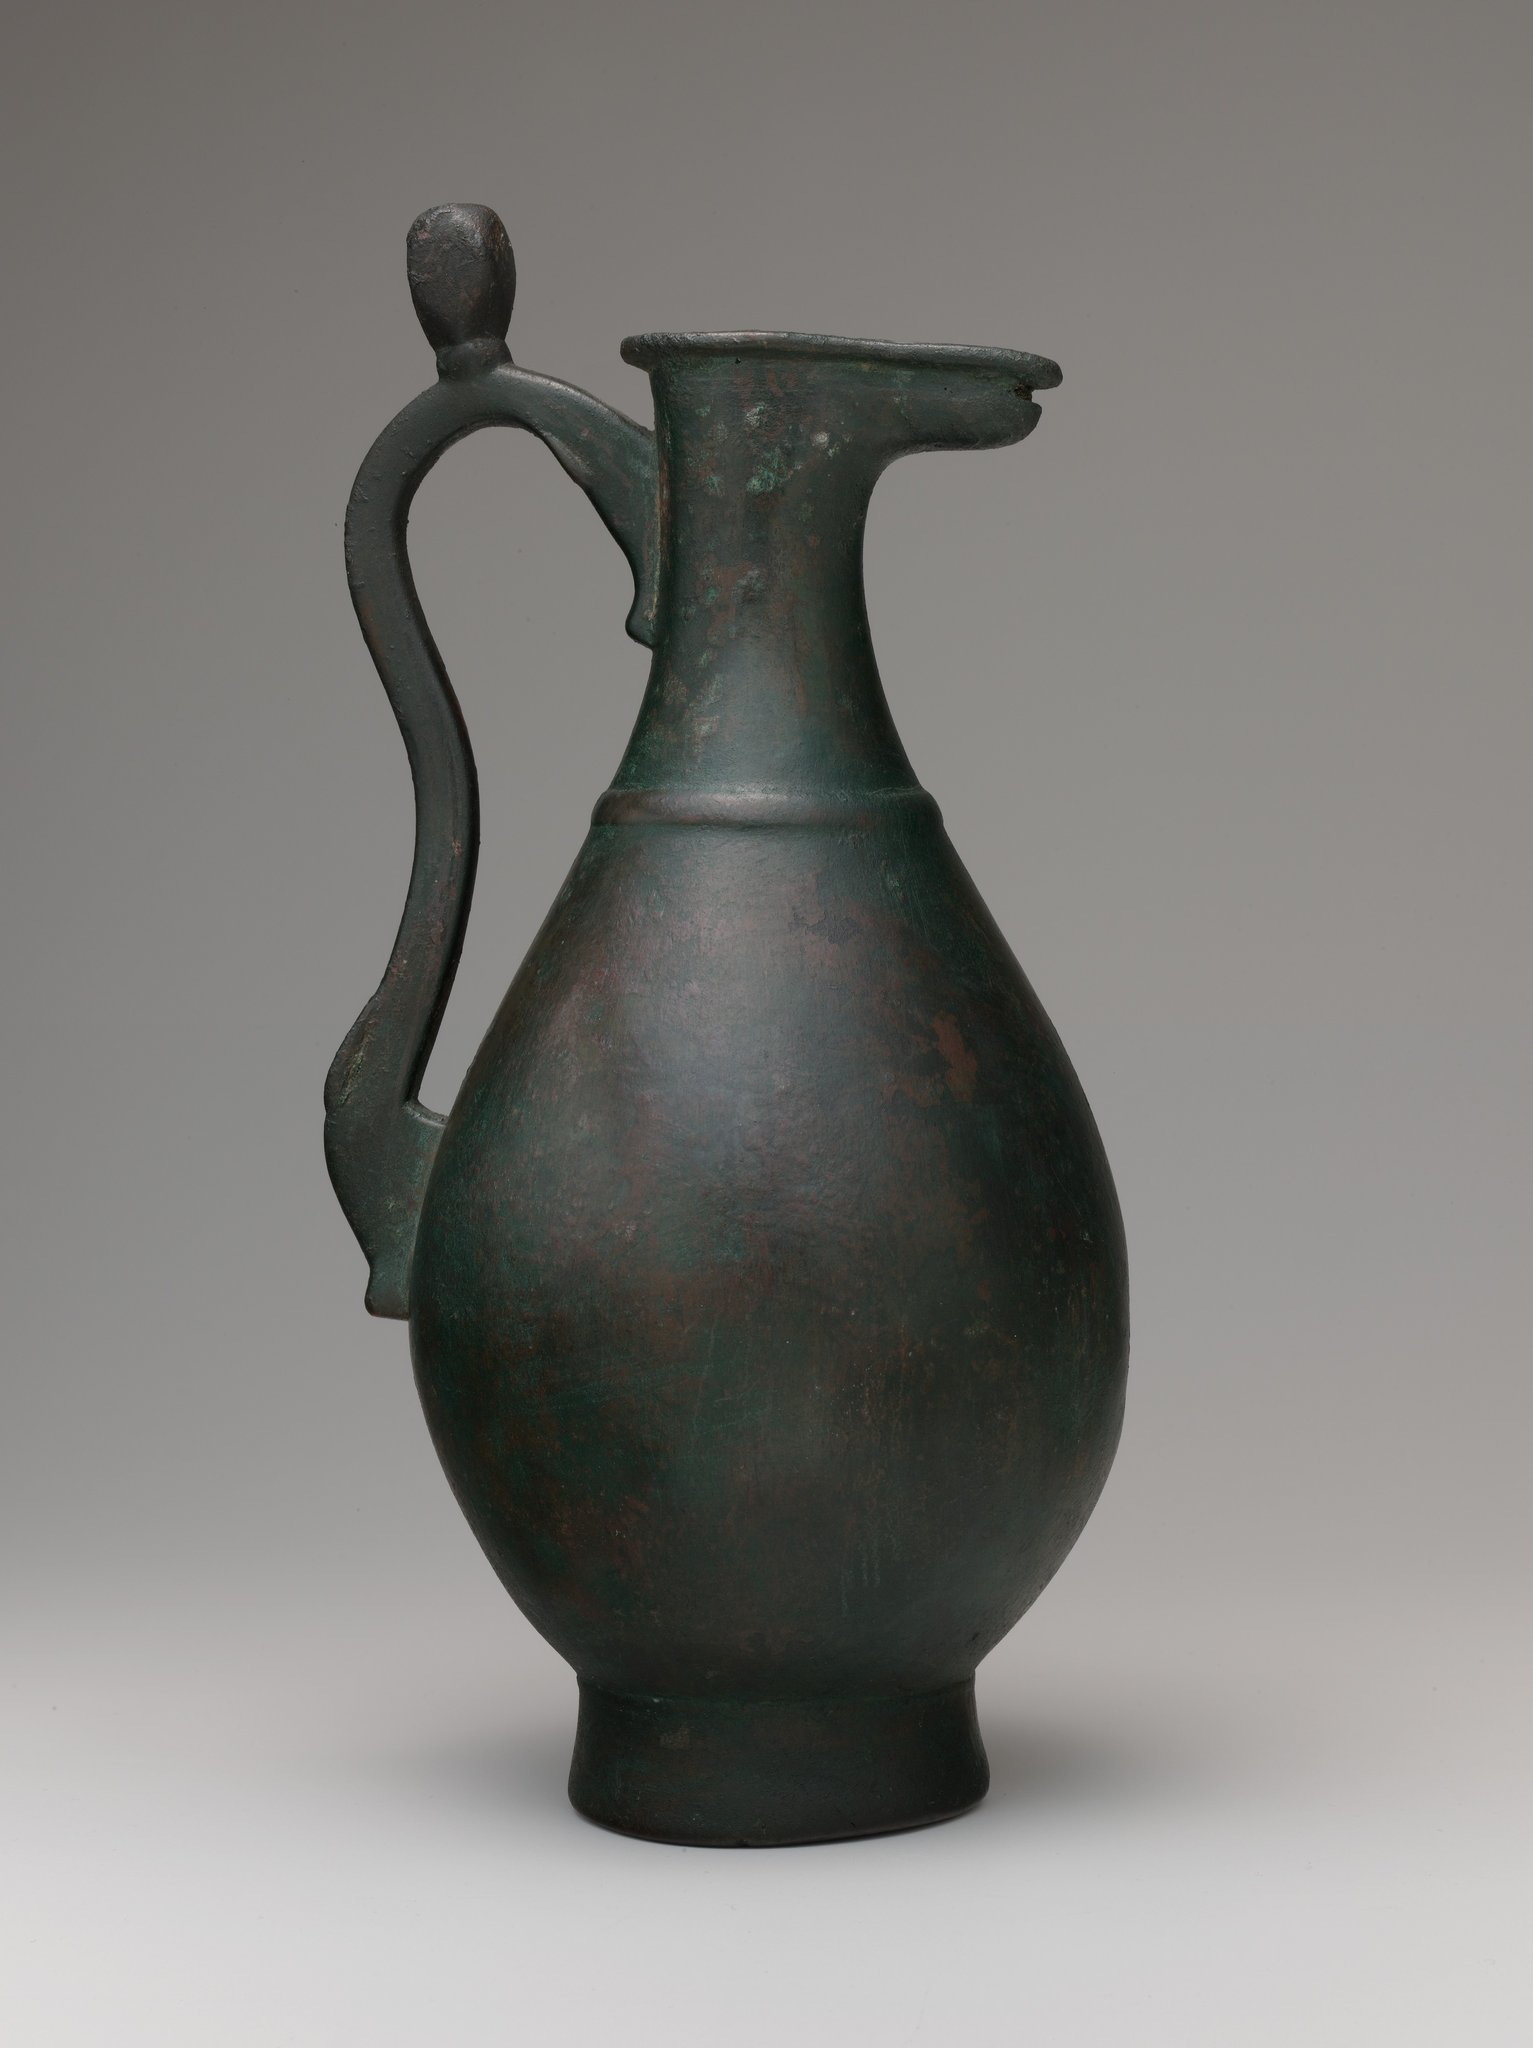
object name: ewer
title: Ewer with Protruding Lip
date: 701-800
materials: bronze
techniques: casting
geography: iran